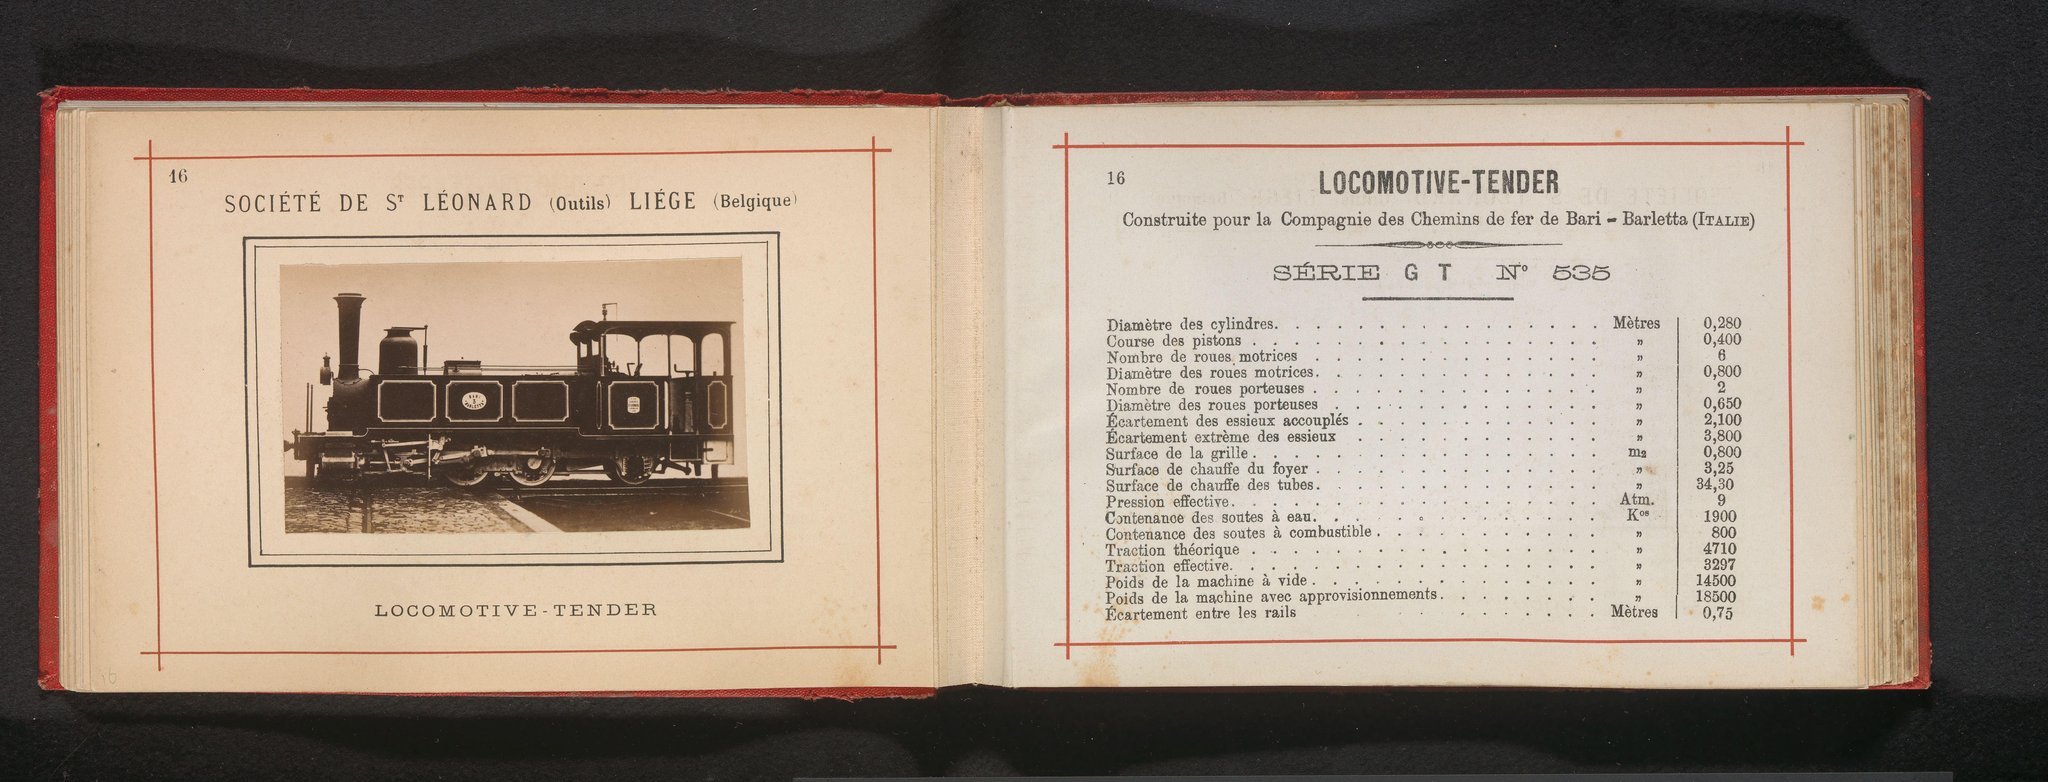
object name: page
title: Tenderlocomotief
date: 1880-1885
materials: photographic support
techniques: albumen print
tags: locomotive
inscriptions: inscription: ‘Société de St. Léonard (Outils) Liége (Belgique)’